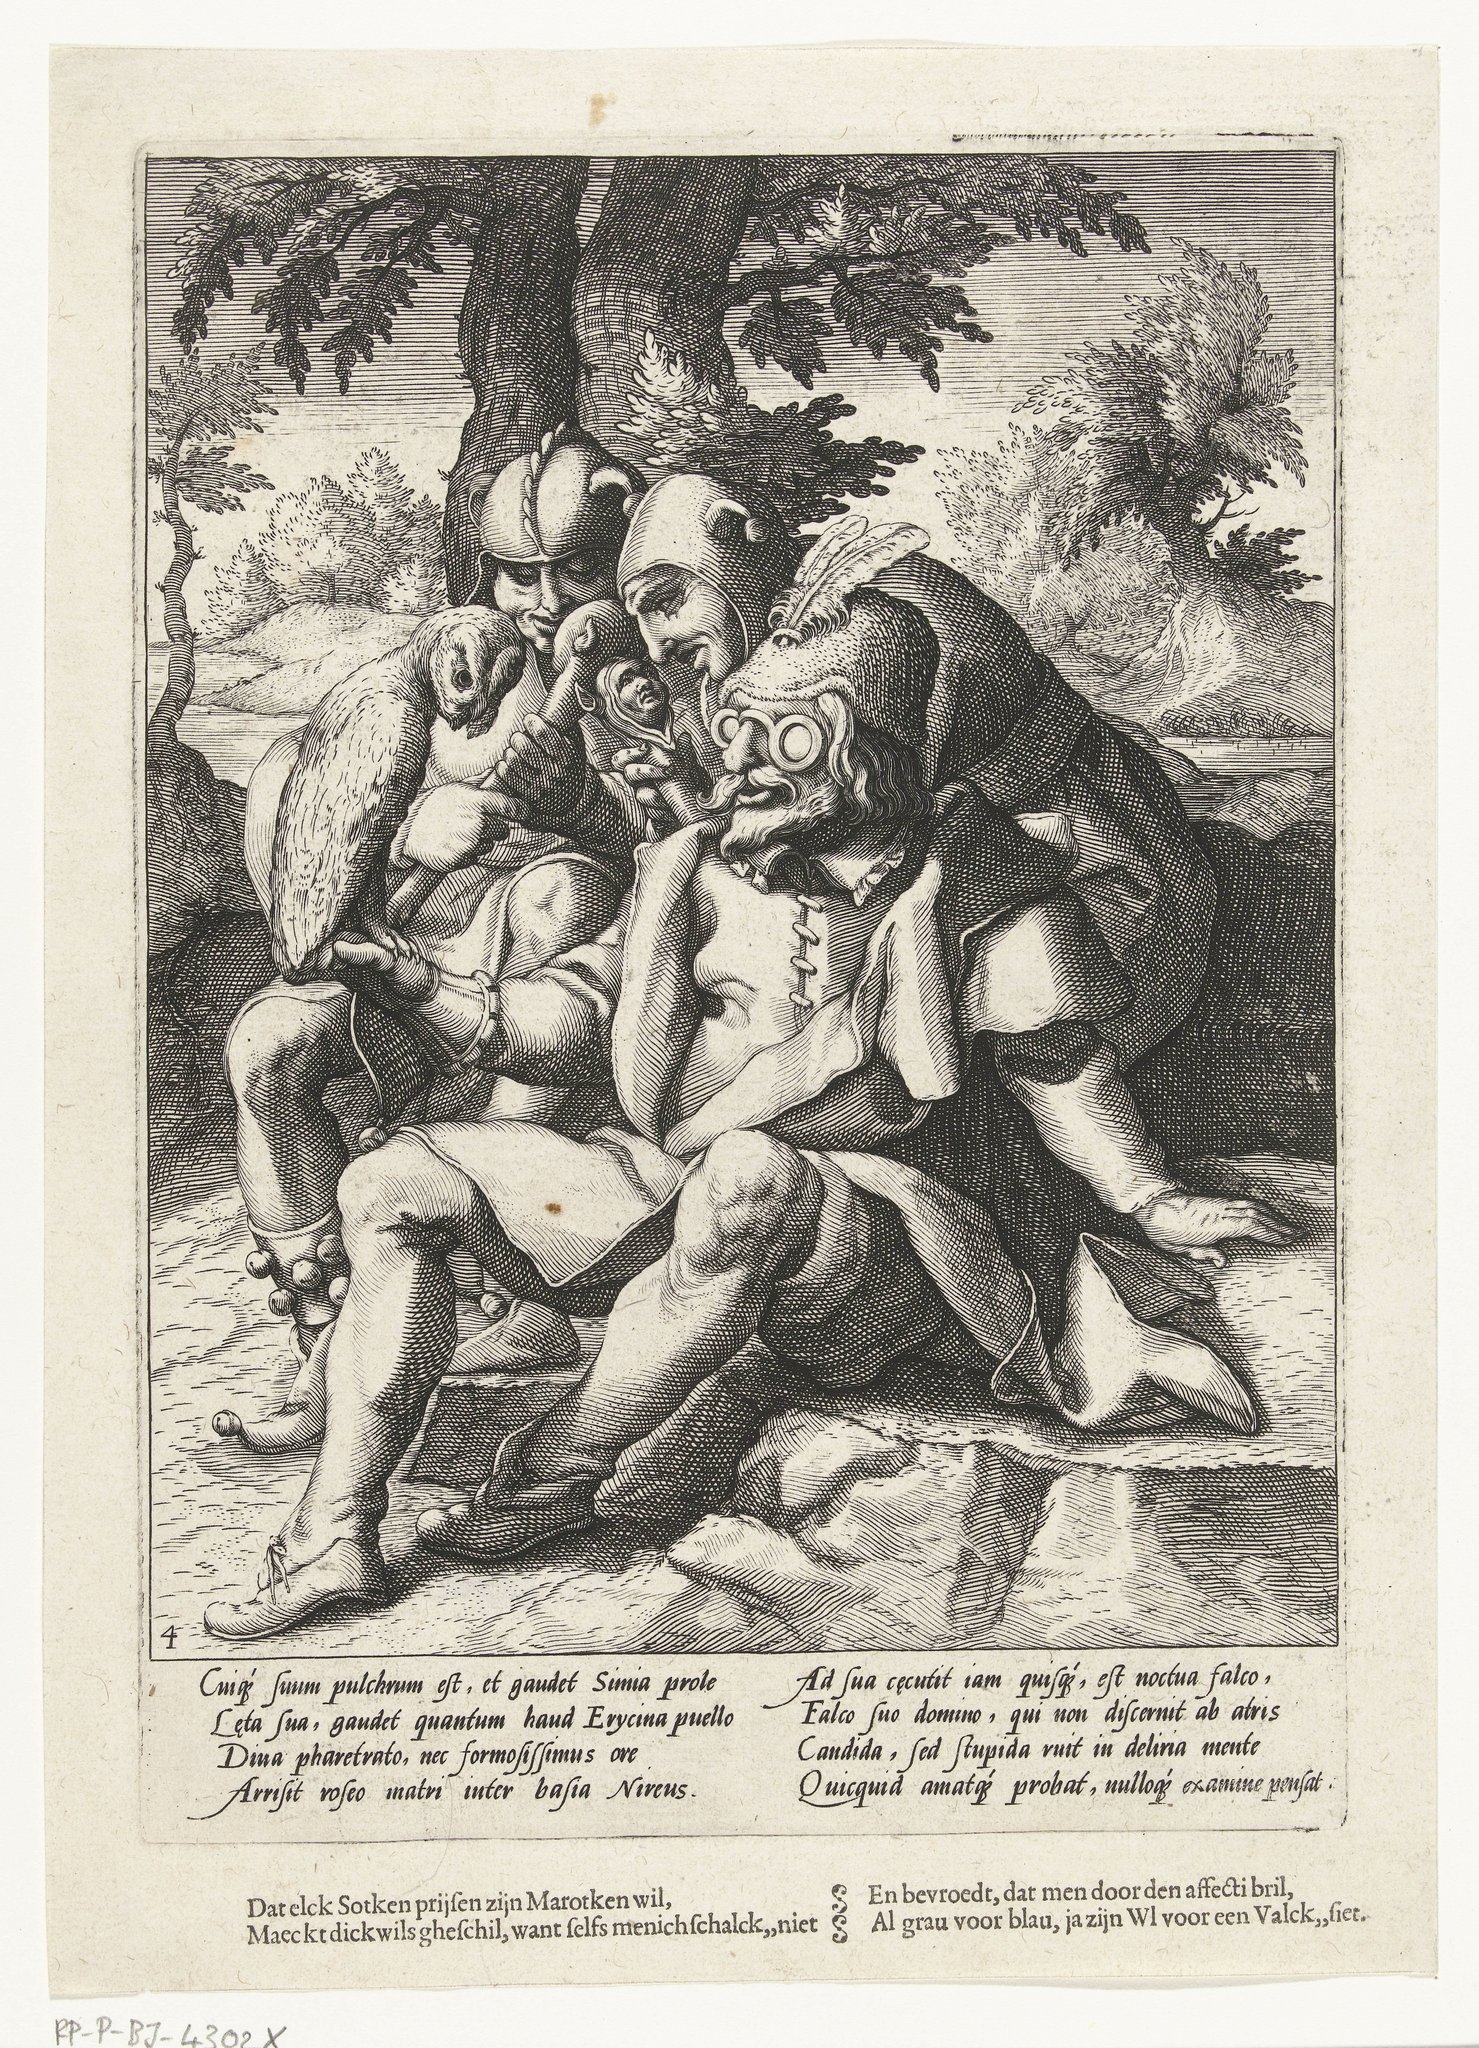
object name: print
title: Elk meent zijn uil een valk te zijn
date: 1590-1594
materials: paper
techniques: engraving, letterpress printing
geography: haarlem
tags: eyeglasses, spectacles, fool, simpleton, numskull, proverbs, sayings, etc., owls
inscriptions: number: ‘4’, caption: ‘Cuis, suum pulchrum est, et gaudet Simia prole...Quicquid amatq[ue] probat, nulloq[ue] examine pensat.’, caption: ‘Dat elck Sotken prysen zijn Marotken wil, Maeckt dicwils geschil, want selfs menich schalck, niet / En bevroedt, dat men door den affecti bril / Al graeu voor blaeu, ja zijn Uyl voor een Valck siet.’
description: Een man zit op de grond en kijkt door zijn bril naar de uil op zijn hand (en denkt een valk te zien). Achter hem twee narren met elk een marot (narrestaf) in de hand. Het spreekwoord beeld de gedachte uit dat iedereen denkt zelf het beste te hebben of te zijn. Onder de voorstelling een verklarend Latijns vers van Franco Estius en een Nederlands tekst in boekdruk.